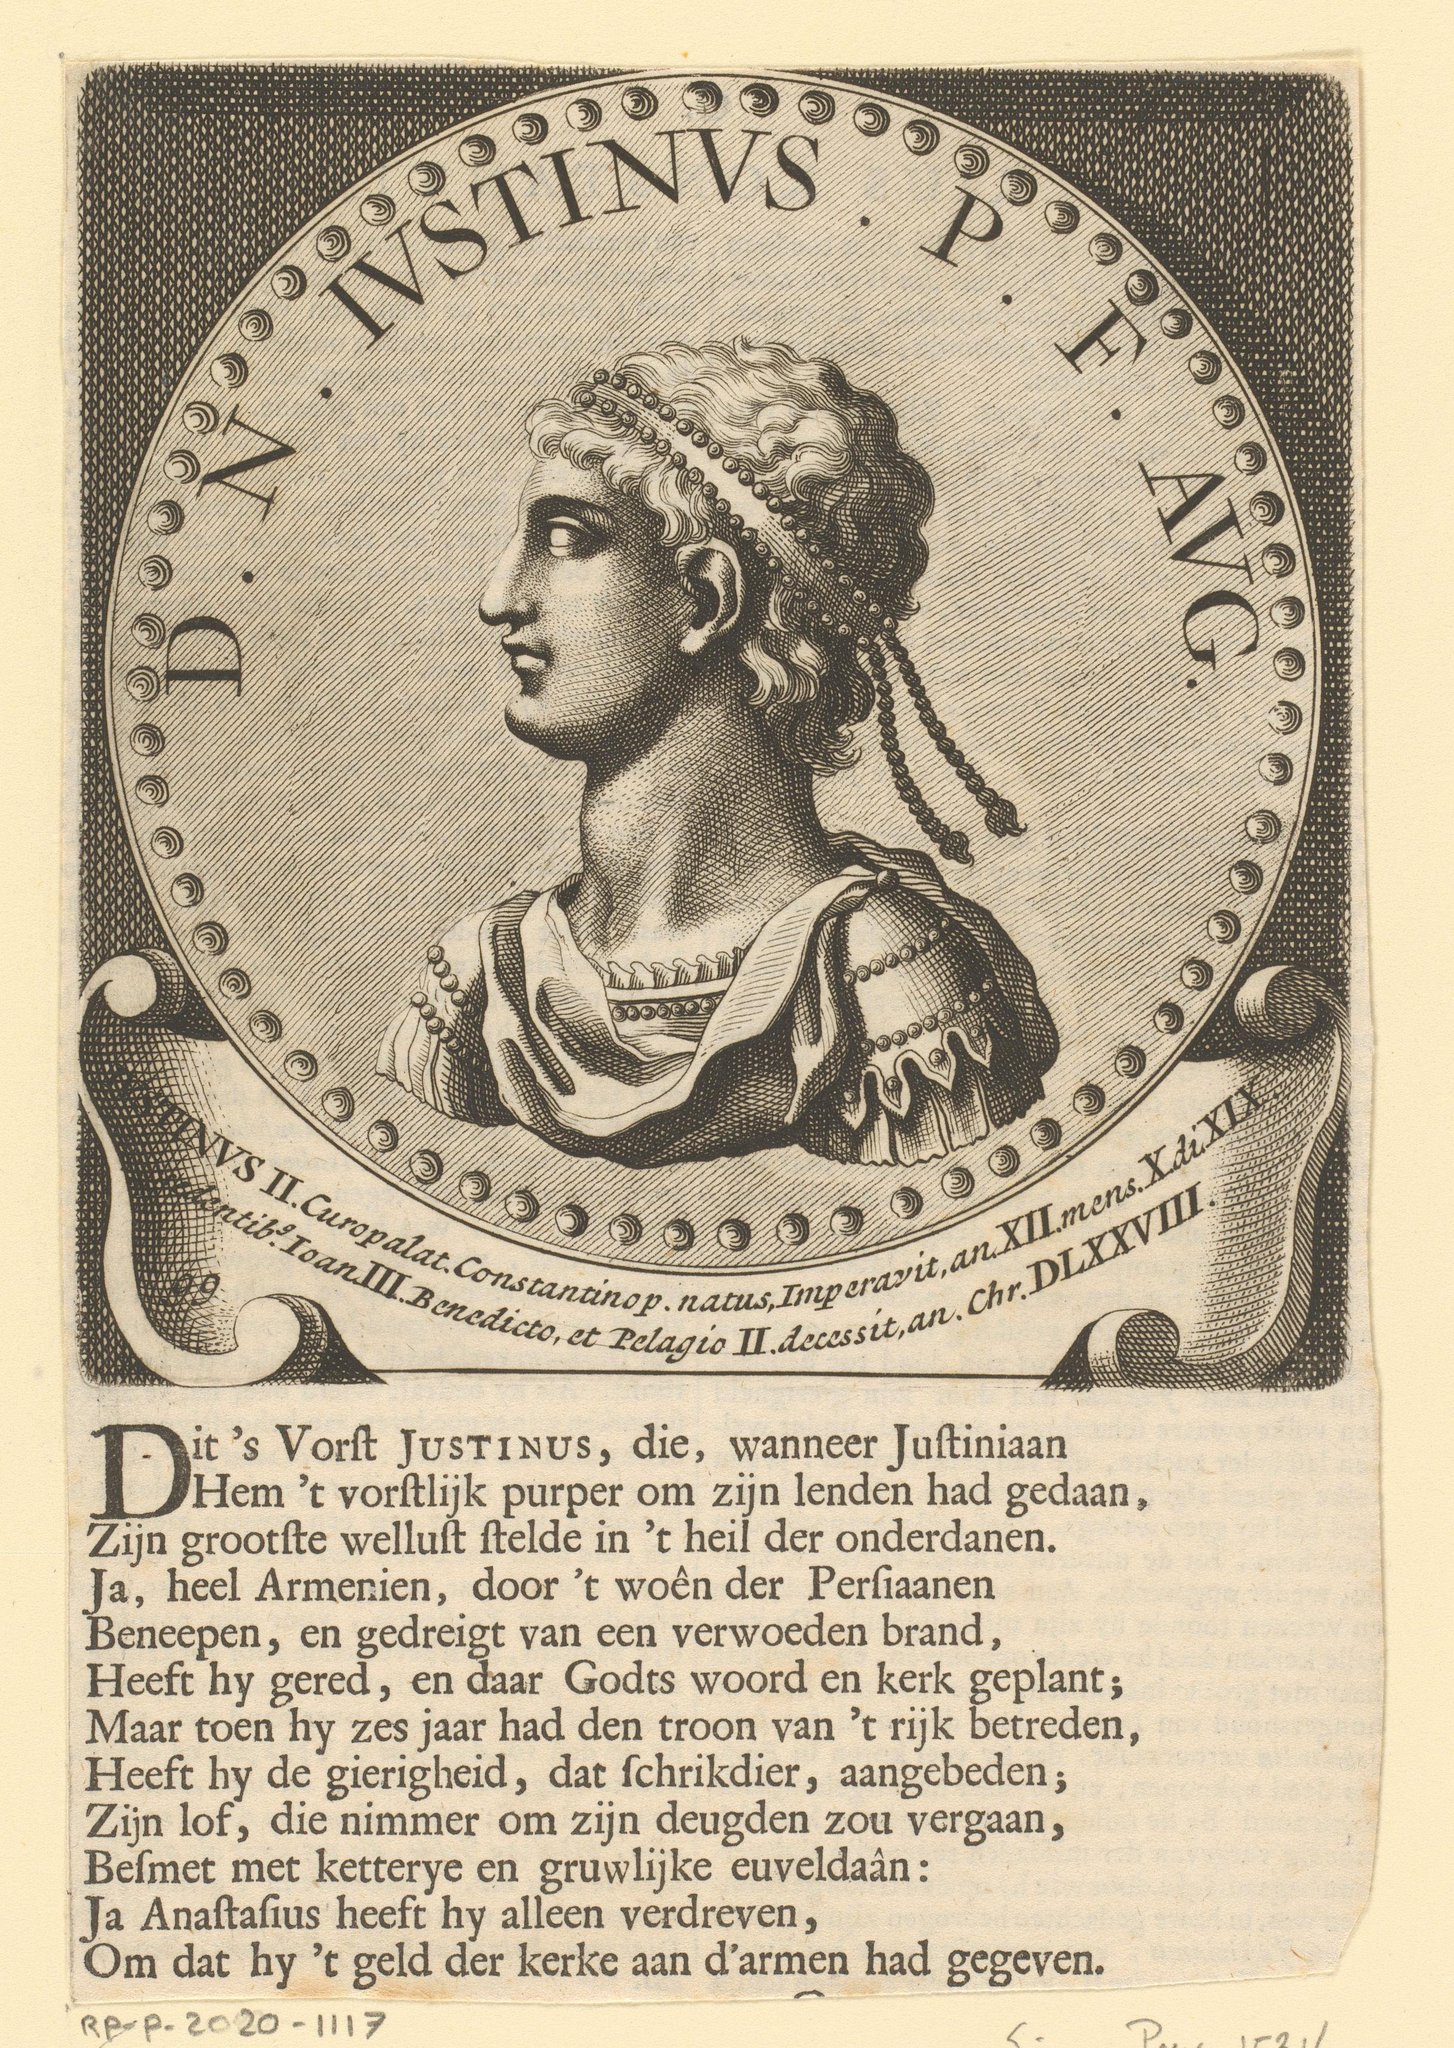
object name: book illustration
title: Portret van keizer Justinus II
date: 1697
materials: paper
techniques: engraving, etching, letterpress printing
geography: utrecht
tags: historical persons, emperor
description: Prent uit: Bogaert, Abraham. De Roomsche monarchy, vertoont in de muntbeelden der westersche en oostersche keizeren (...). Utrecht: François Halma en Willem van de Water, 1697, p. 305. Eerste staat verschenen in een grotere prent met twaalf portretten, gedateerd 1695.